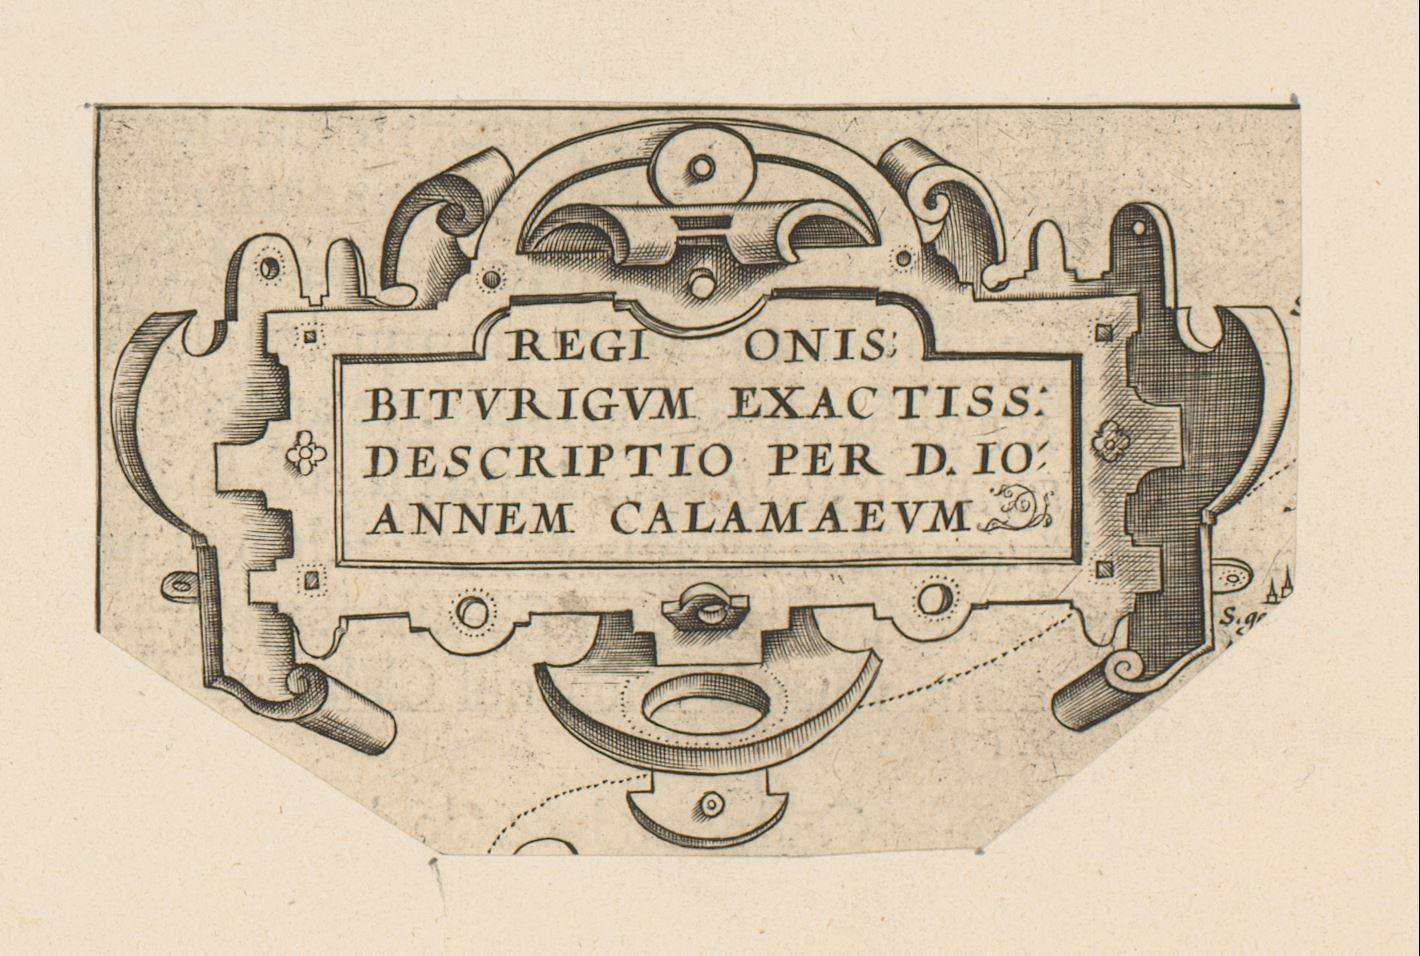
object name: album leaf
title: Theatrum Orbis Terrarum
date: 1570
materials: paper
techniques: engraving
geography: antwerp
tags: scrollwork, strapwork ~ ornament, ornament ~ cartouche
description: De cartouche is gekopieerd naar een prent van een anonieme graveur naar het ontwerp van Hans Vredeman de Vries, onderdeel van een serie van rolwerkcartouches uit circa 1555-1560.